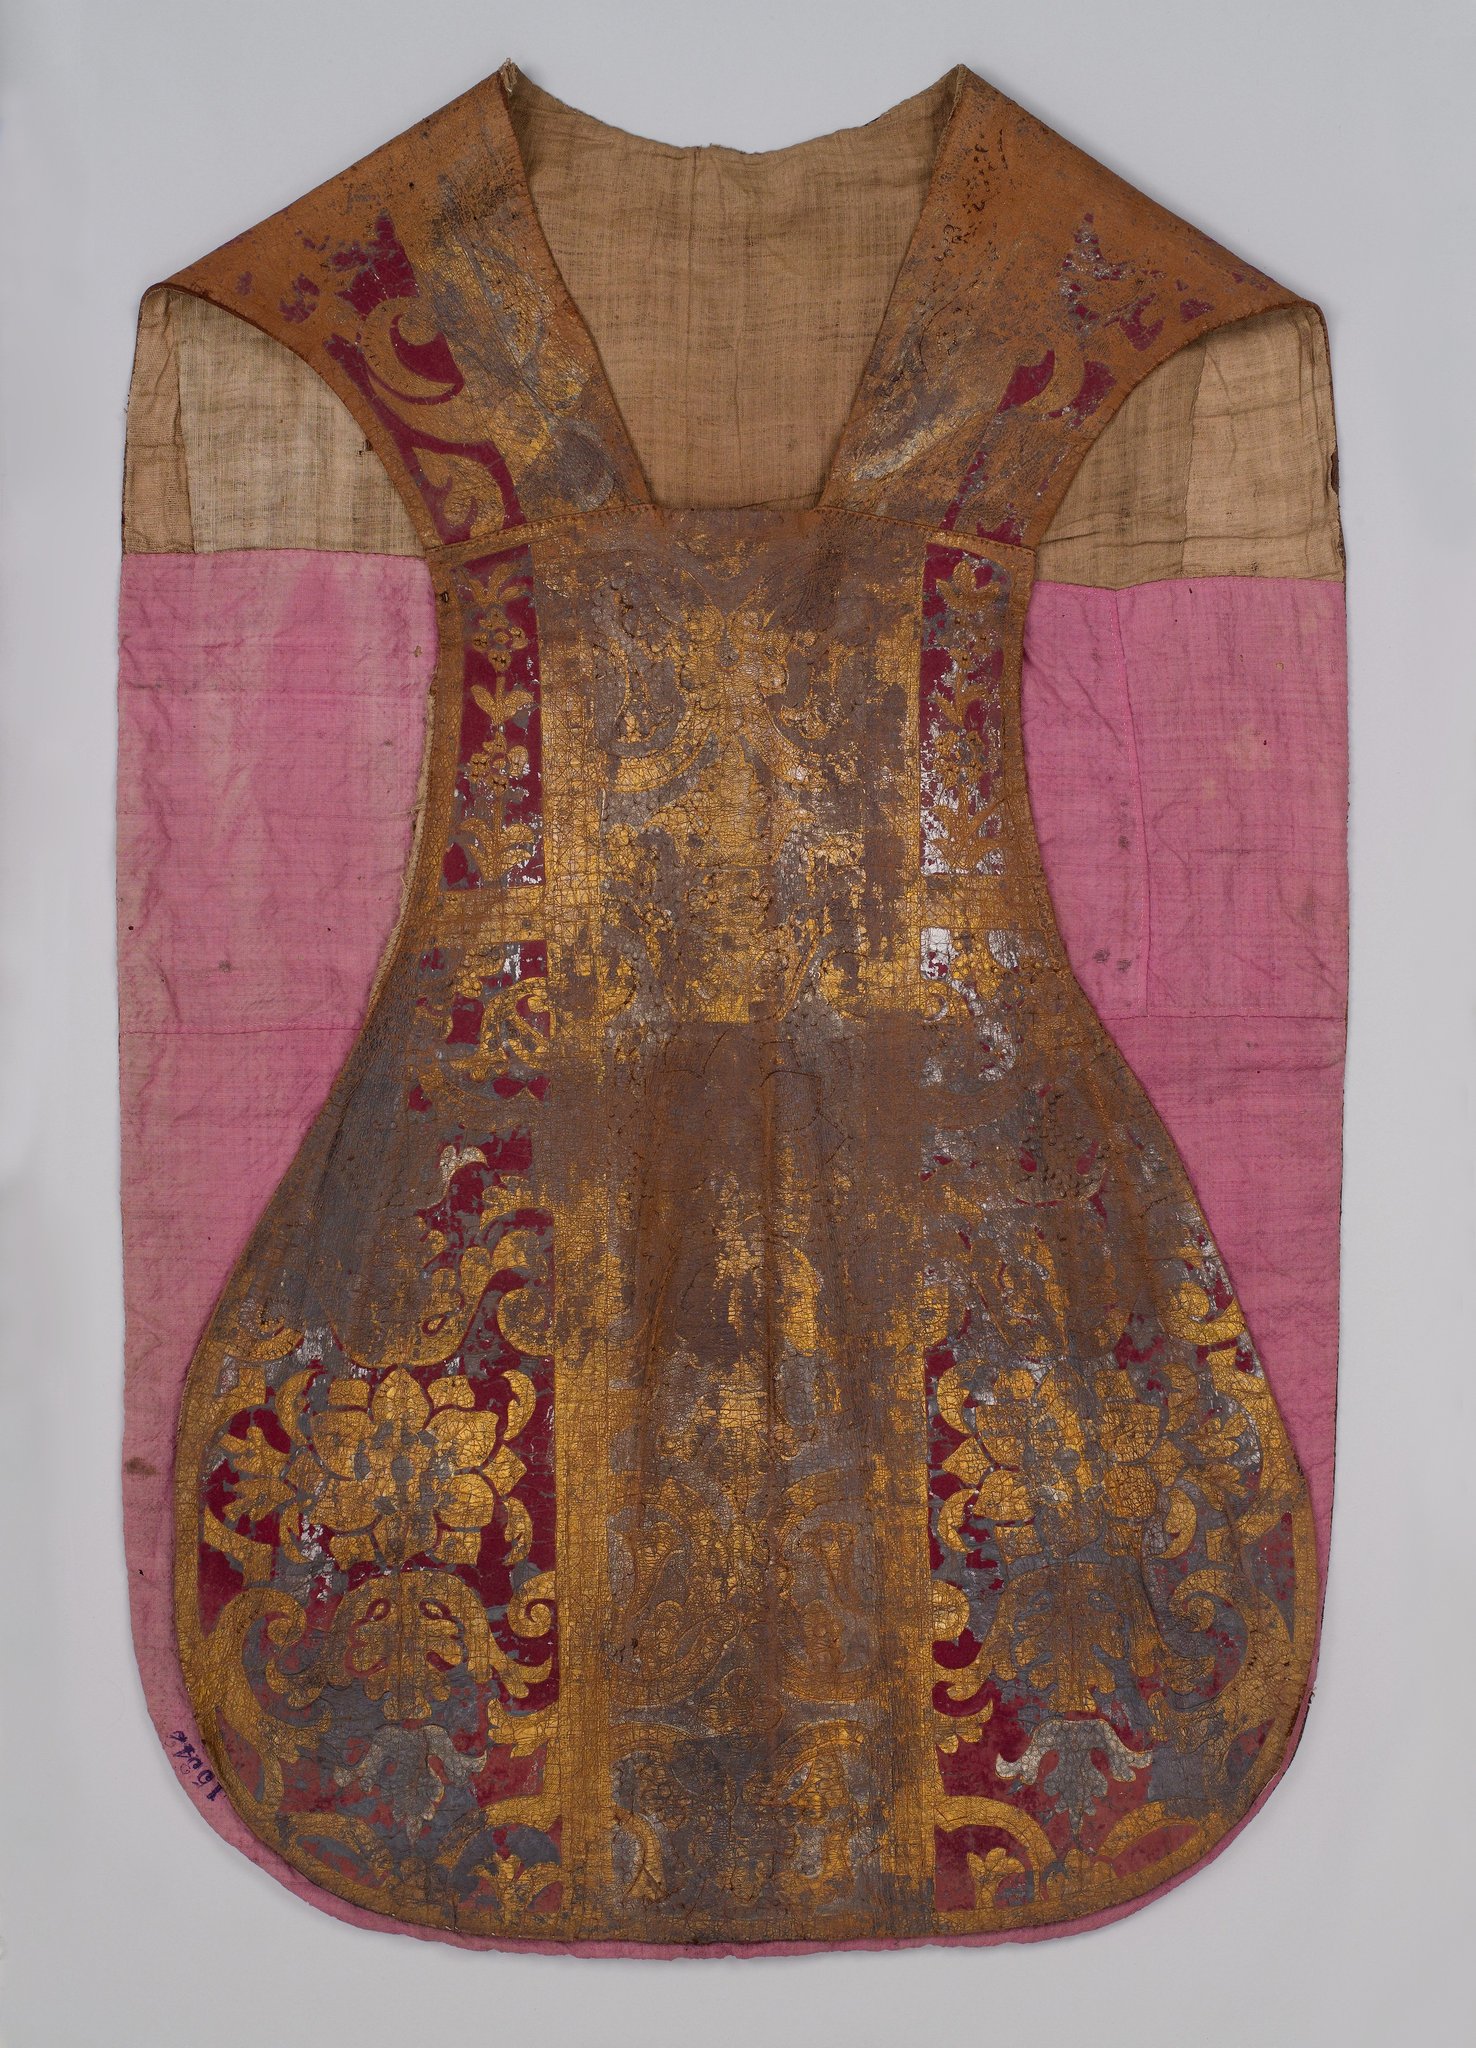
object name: chasuble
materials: leather, metal leaf, wool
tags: flowers